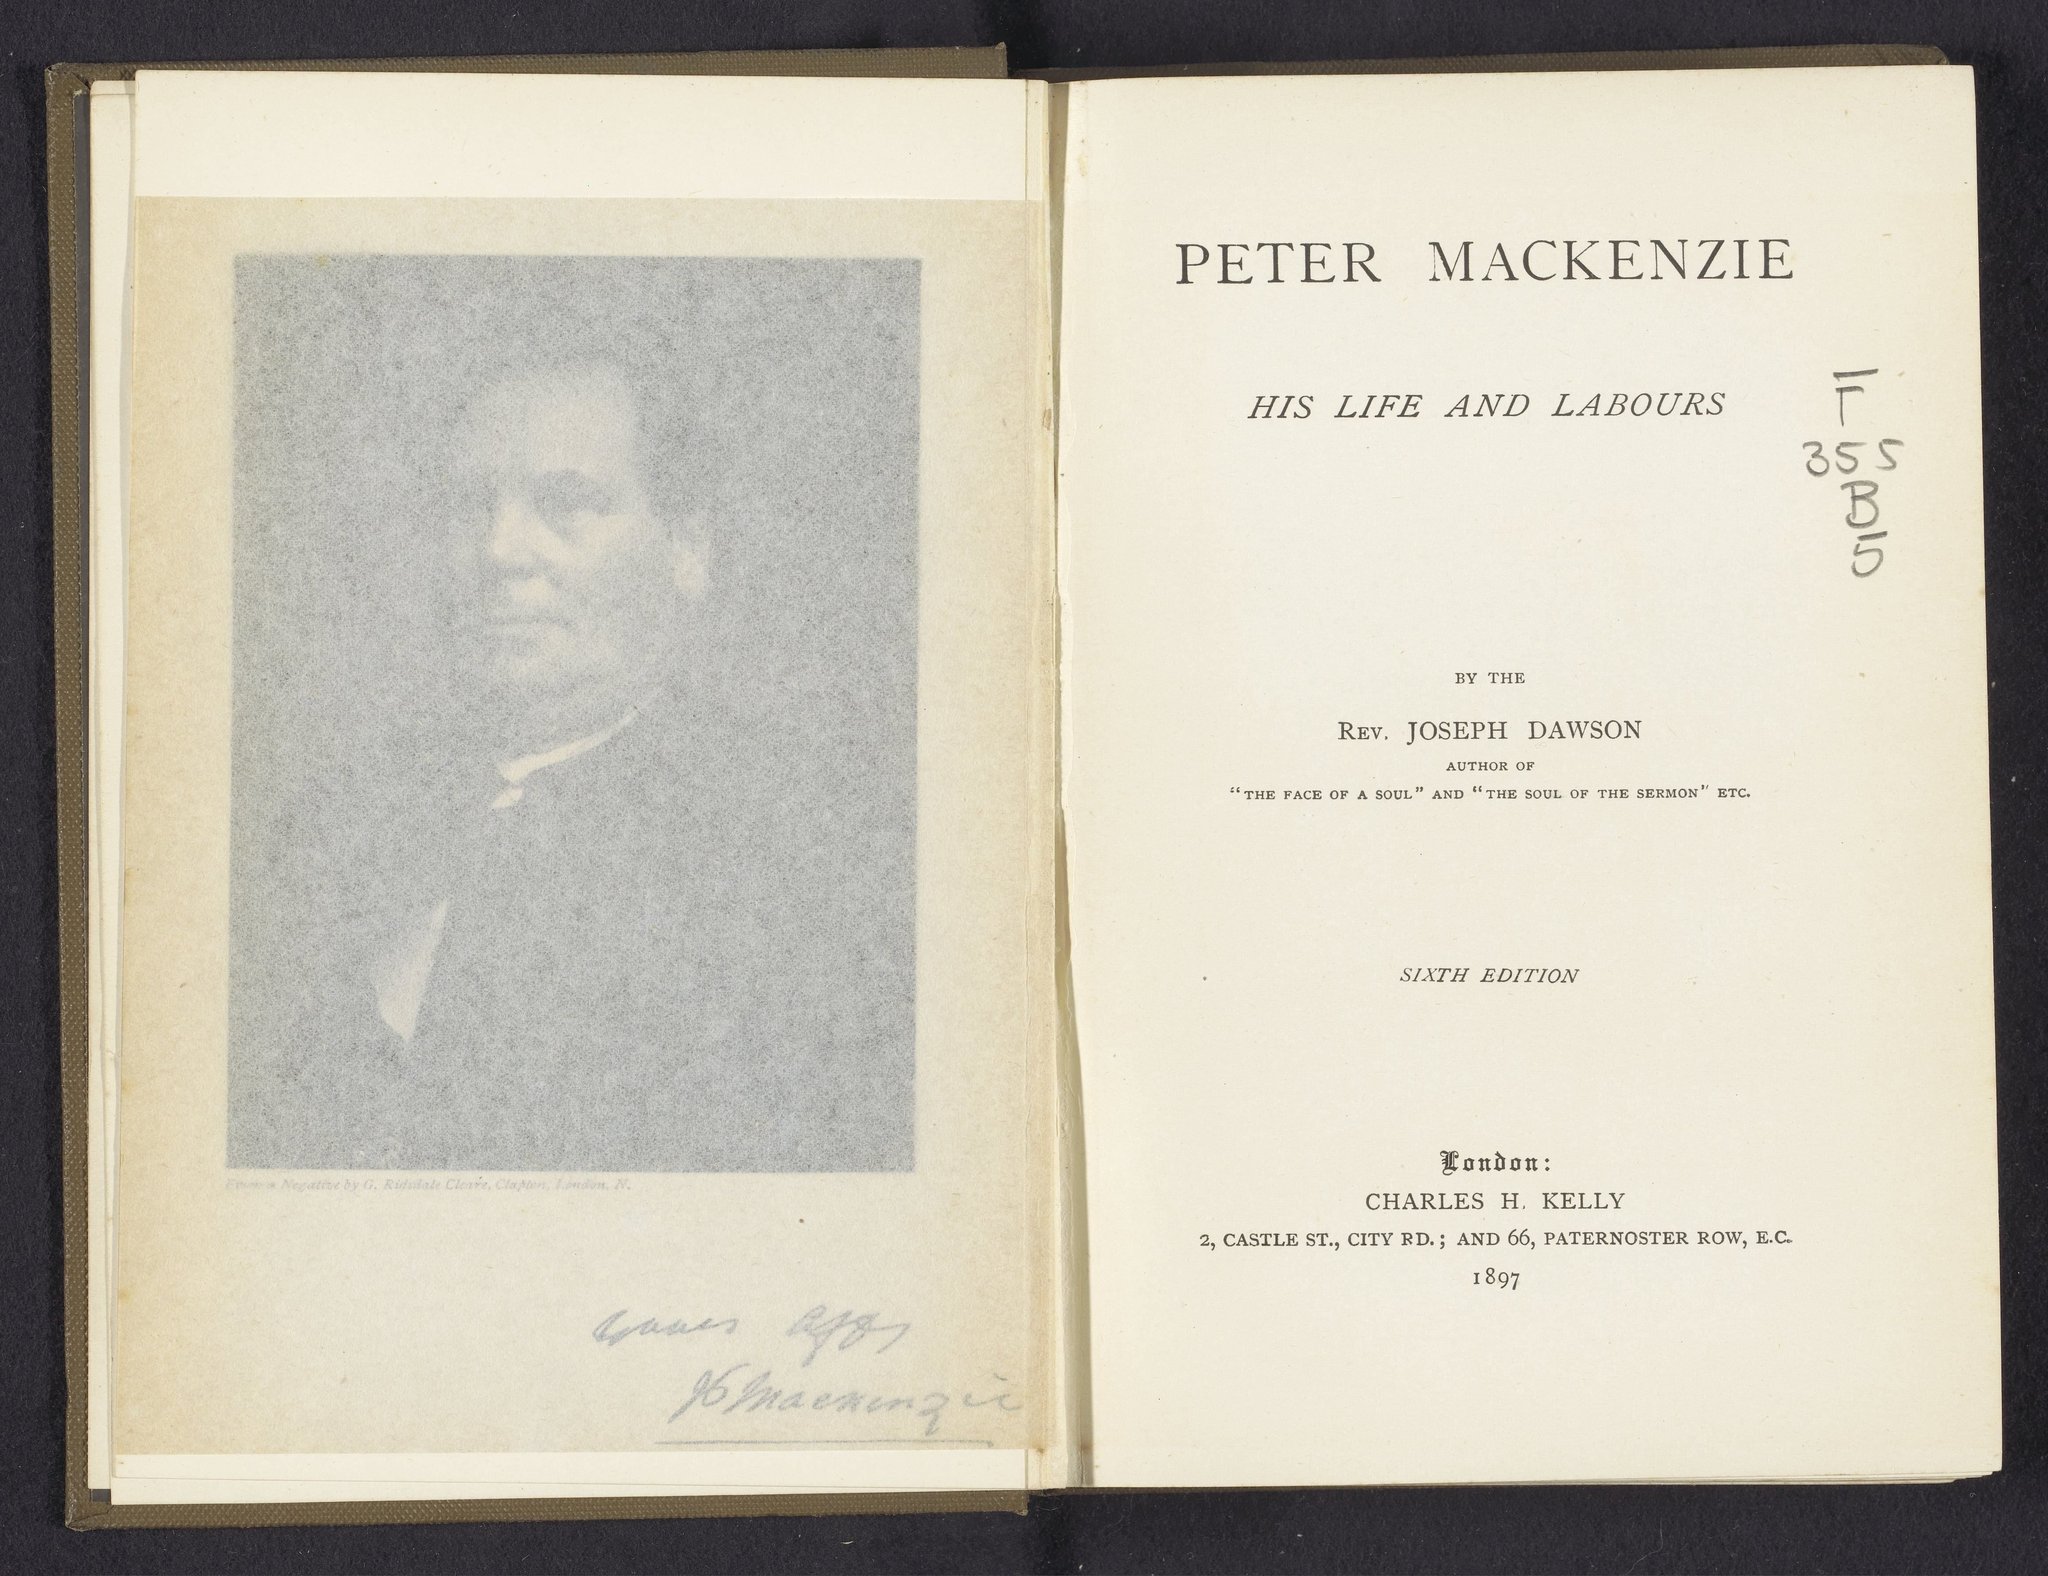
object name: book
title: Peter Mackenzie his life and labours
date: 1897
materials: cardboard, linen, paper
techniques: printing, woodburytype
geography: london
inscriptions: name: ‘Mary Mitchell Janry 1st 1894’